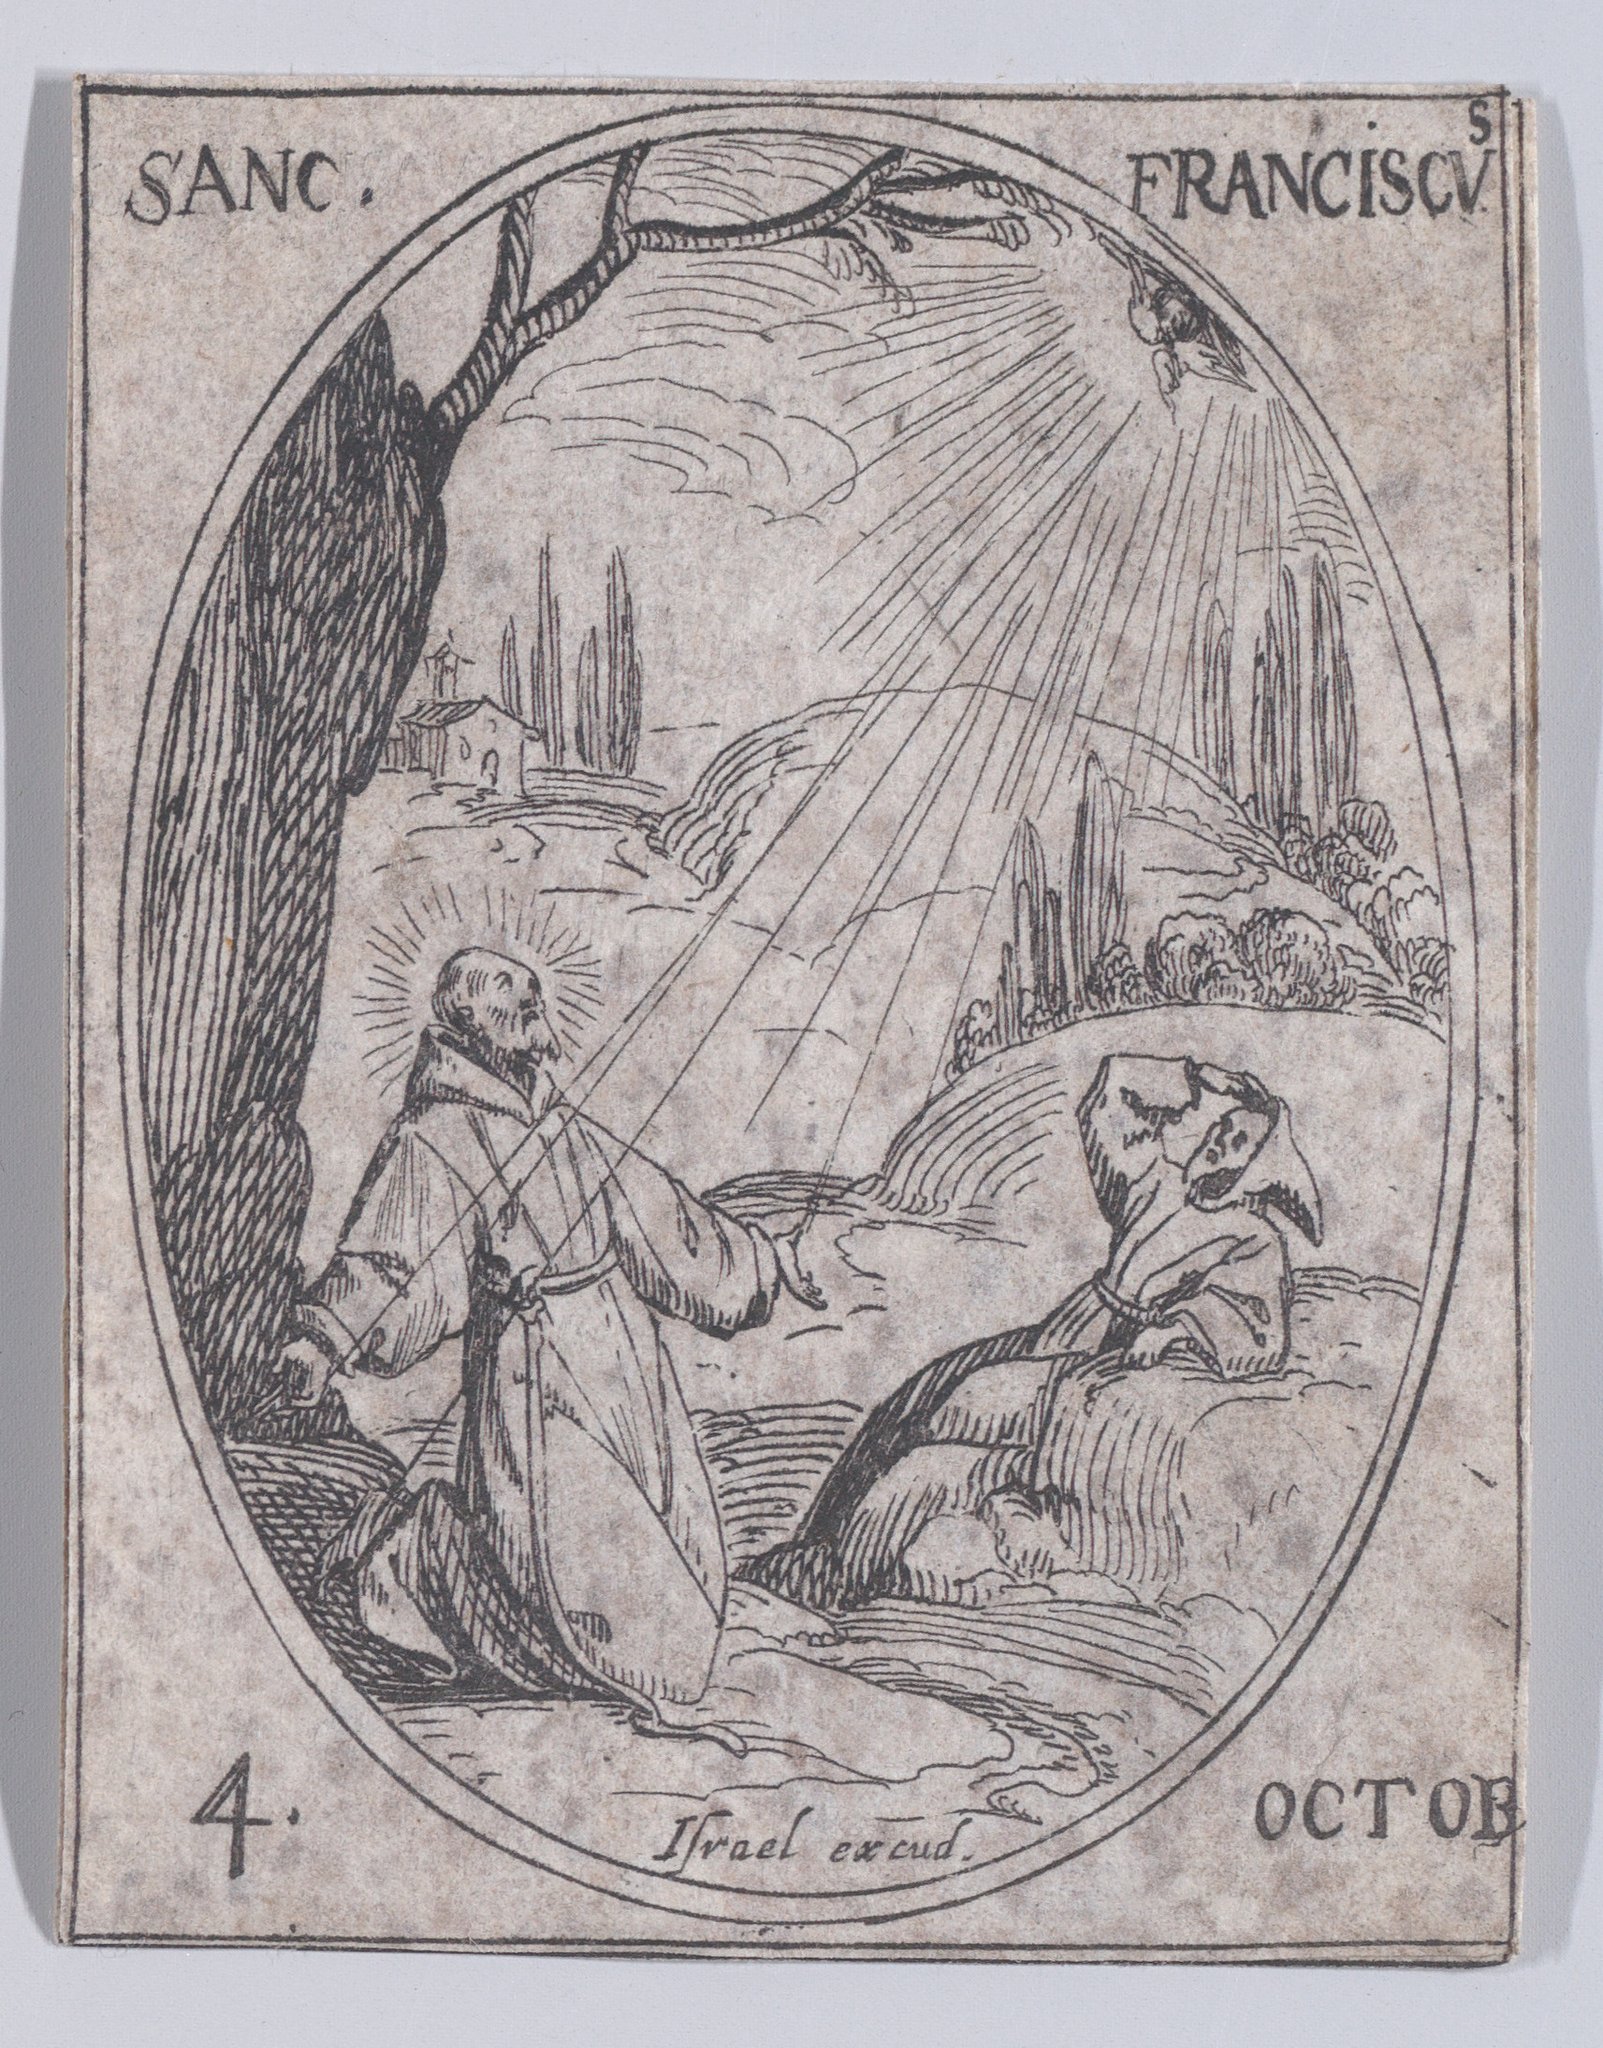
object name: print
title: S. François (St. Francis), October 4th, from "Les Images De Tous Les Saincts et Saintes de L'Année" (Images of All of the Saints and Religious Events of the Year)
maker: jacques callot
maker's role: artist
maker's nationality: french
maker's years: 1592-1635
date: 1636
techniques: etching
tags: men,saint francis